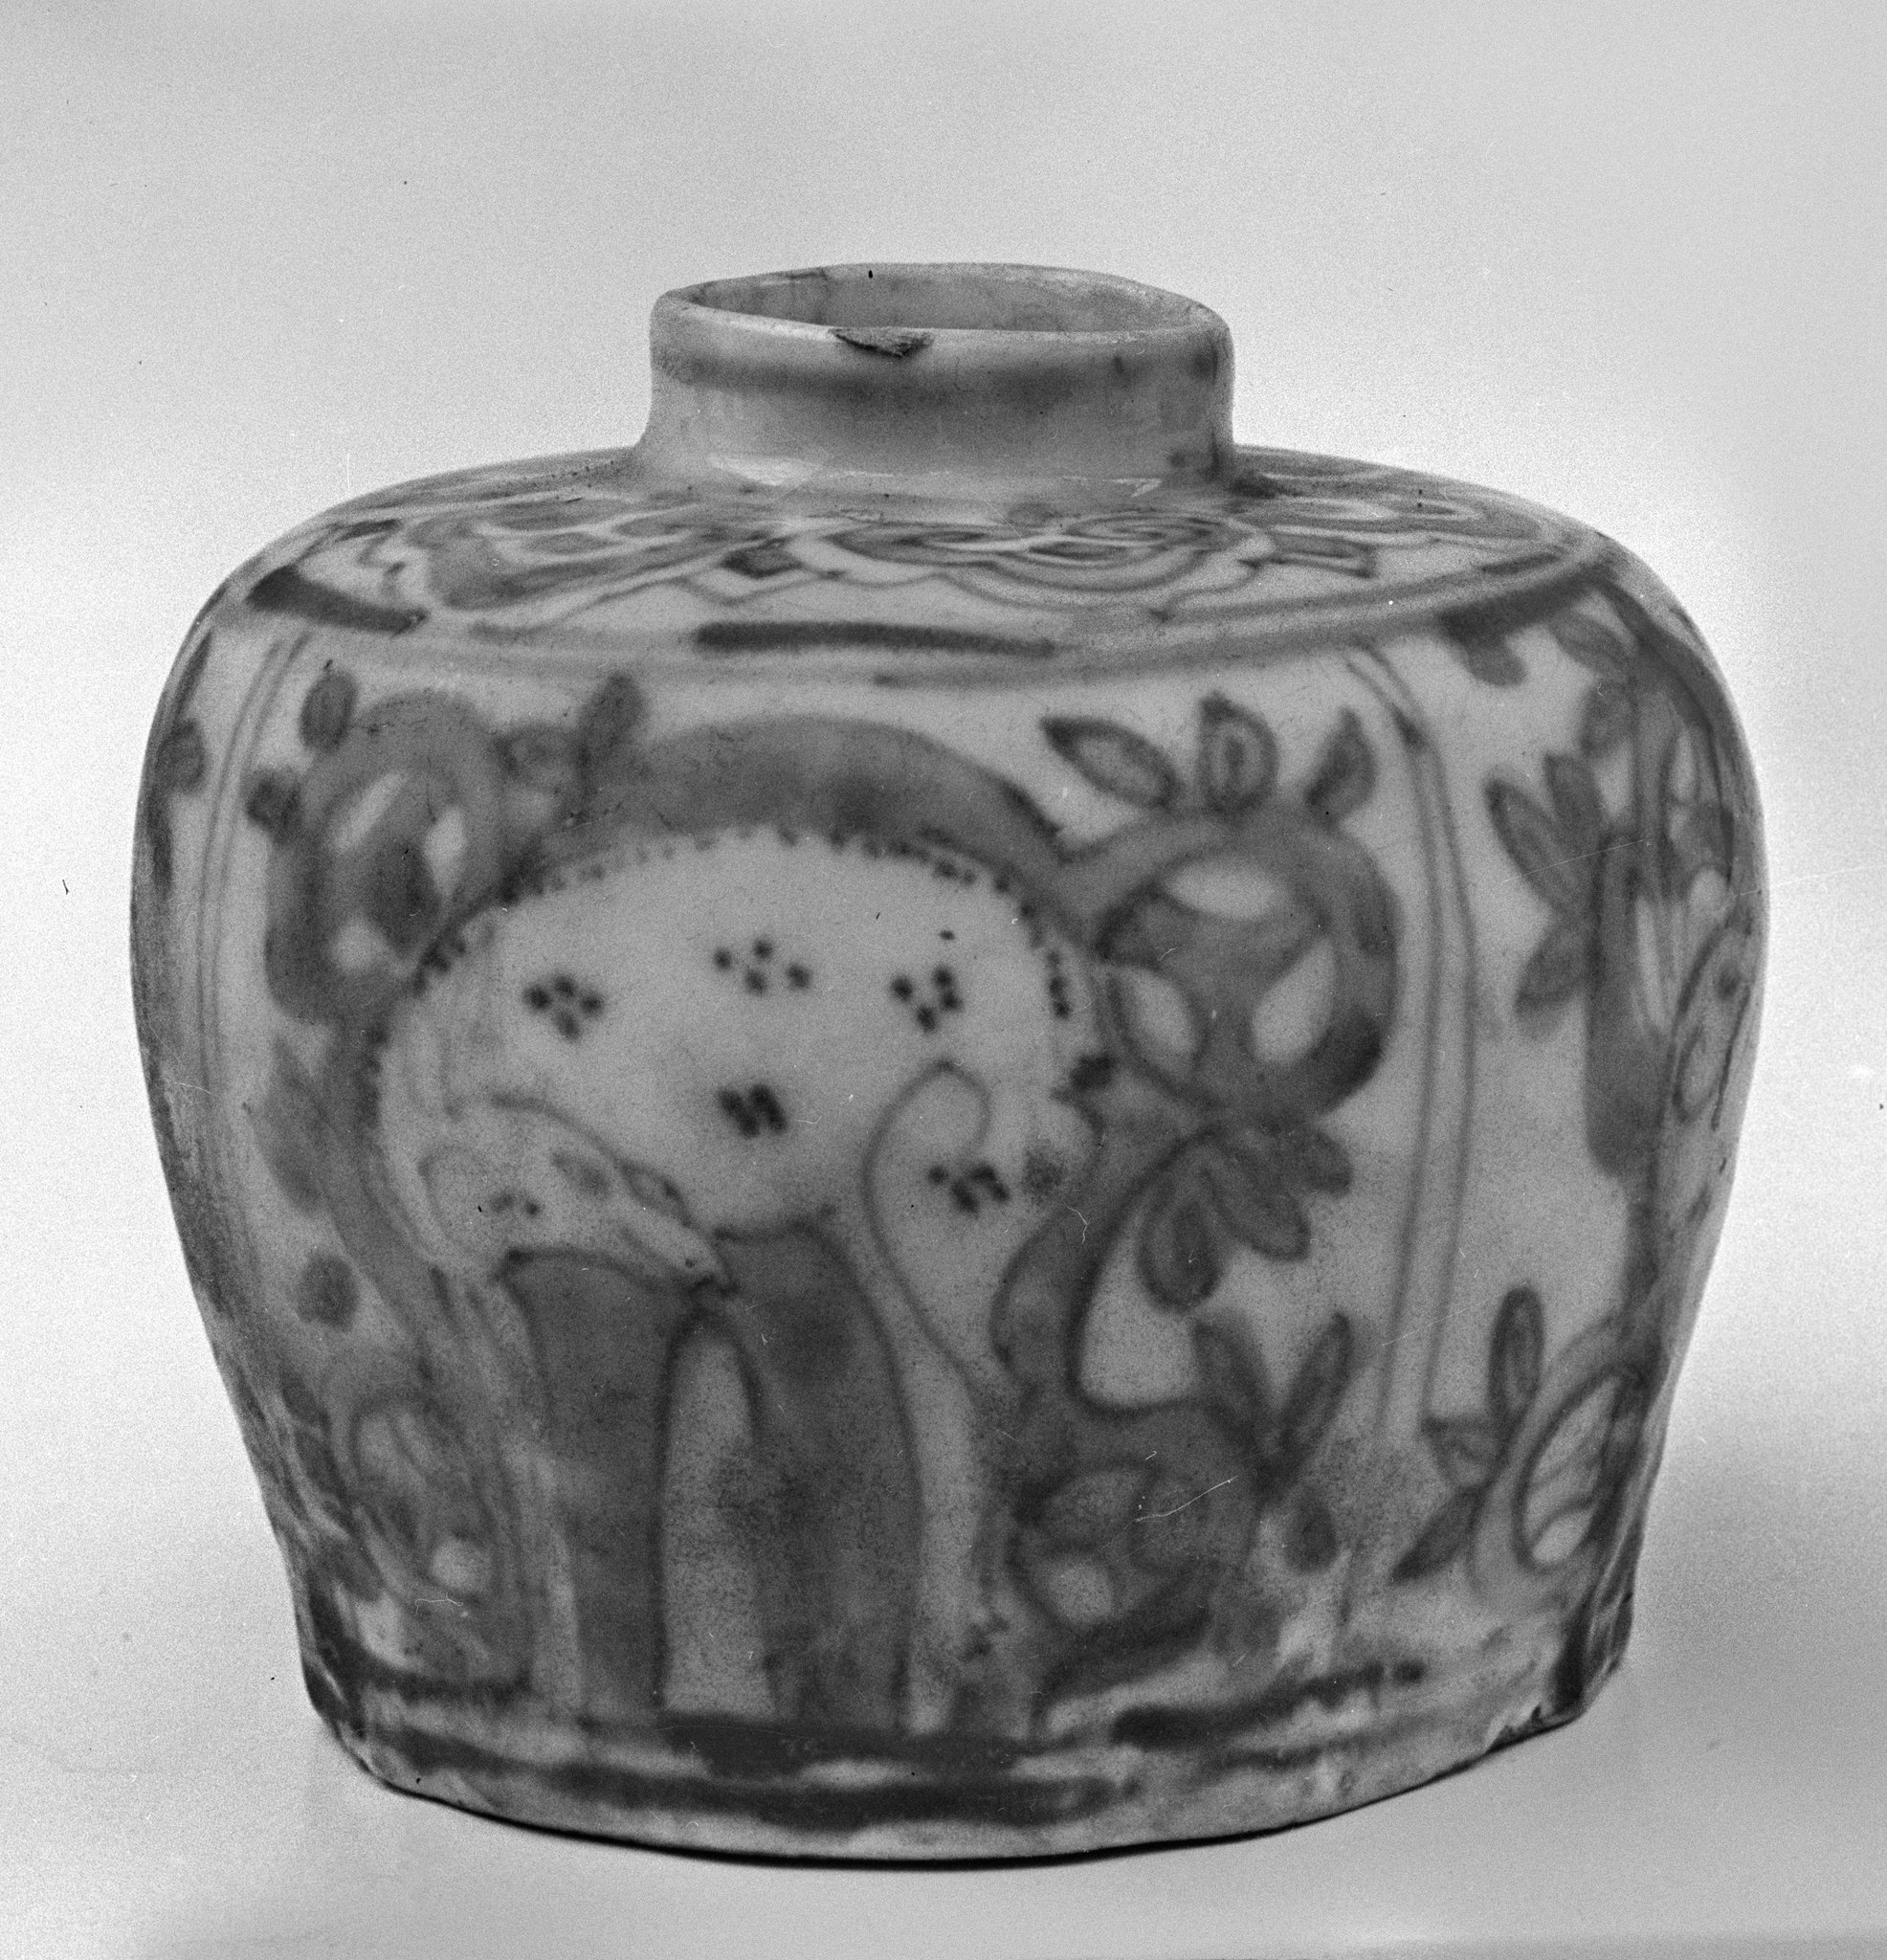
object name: jar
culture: chinese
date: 1368-1644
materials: porcelain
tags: deer